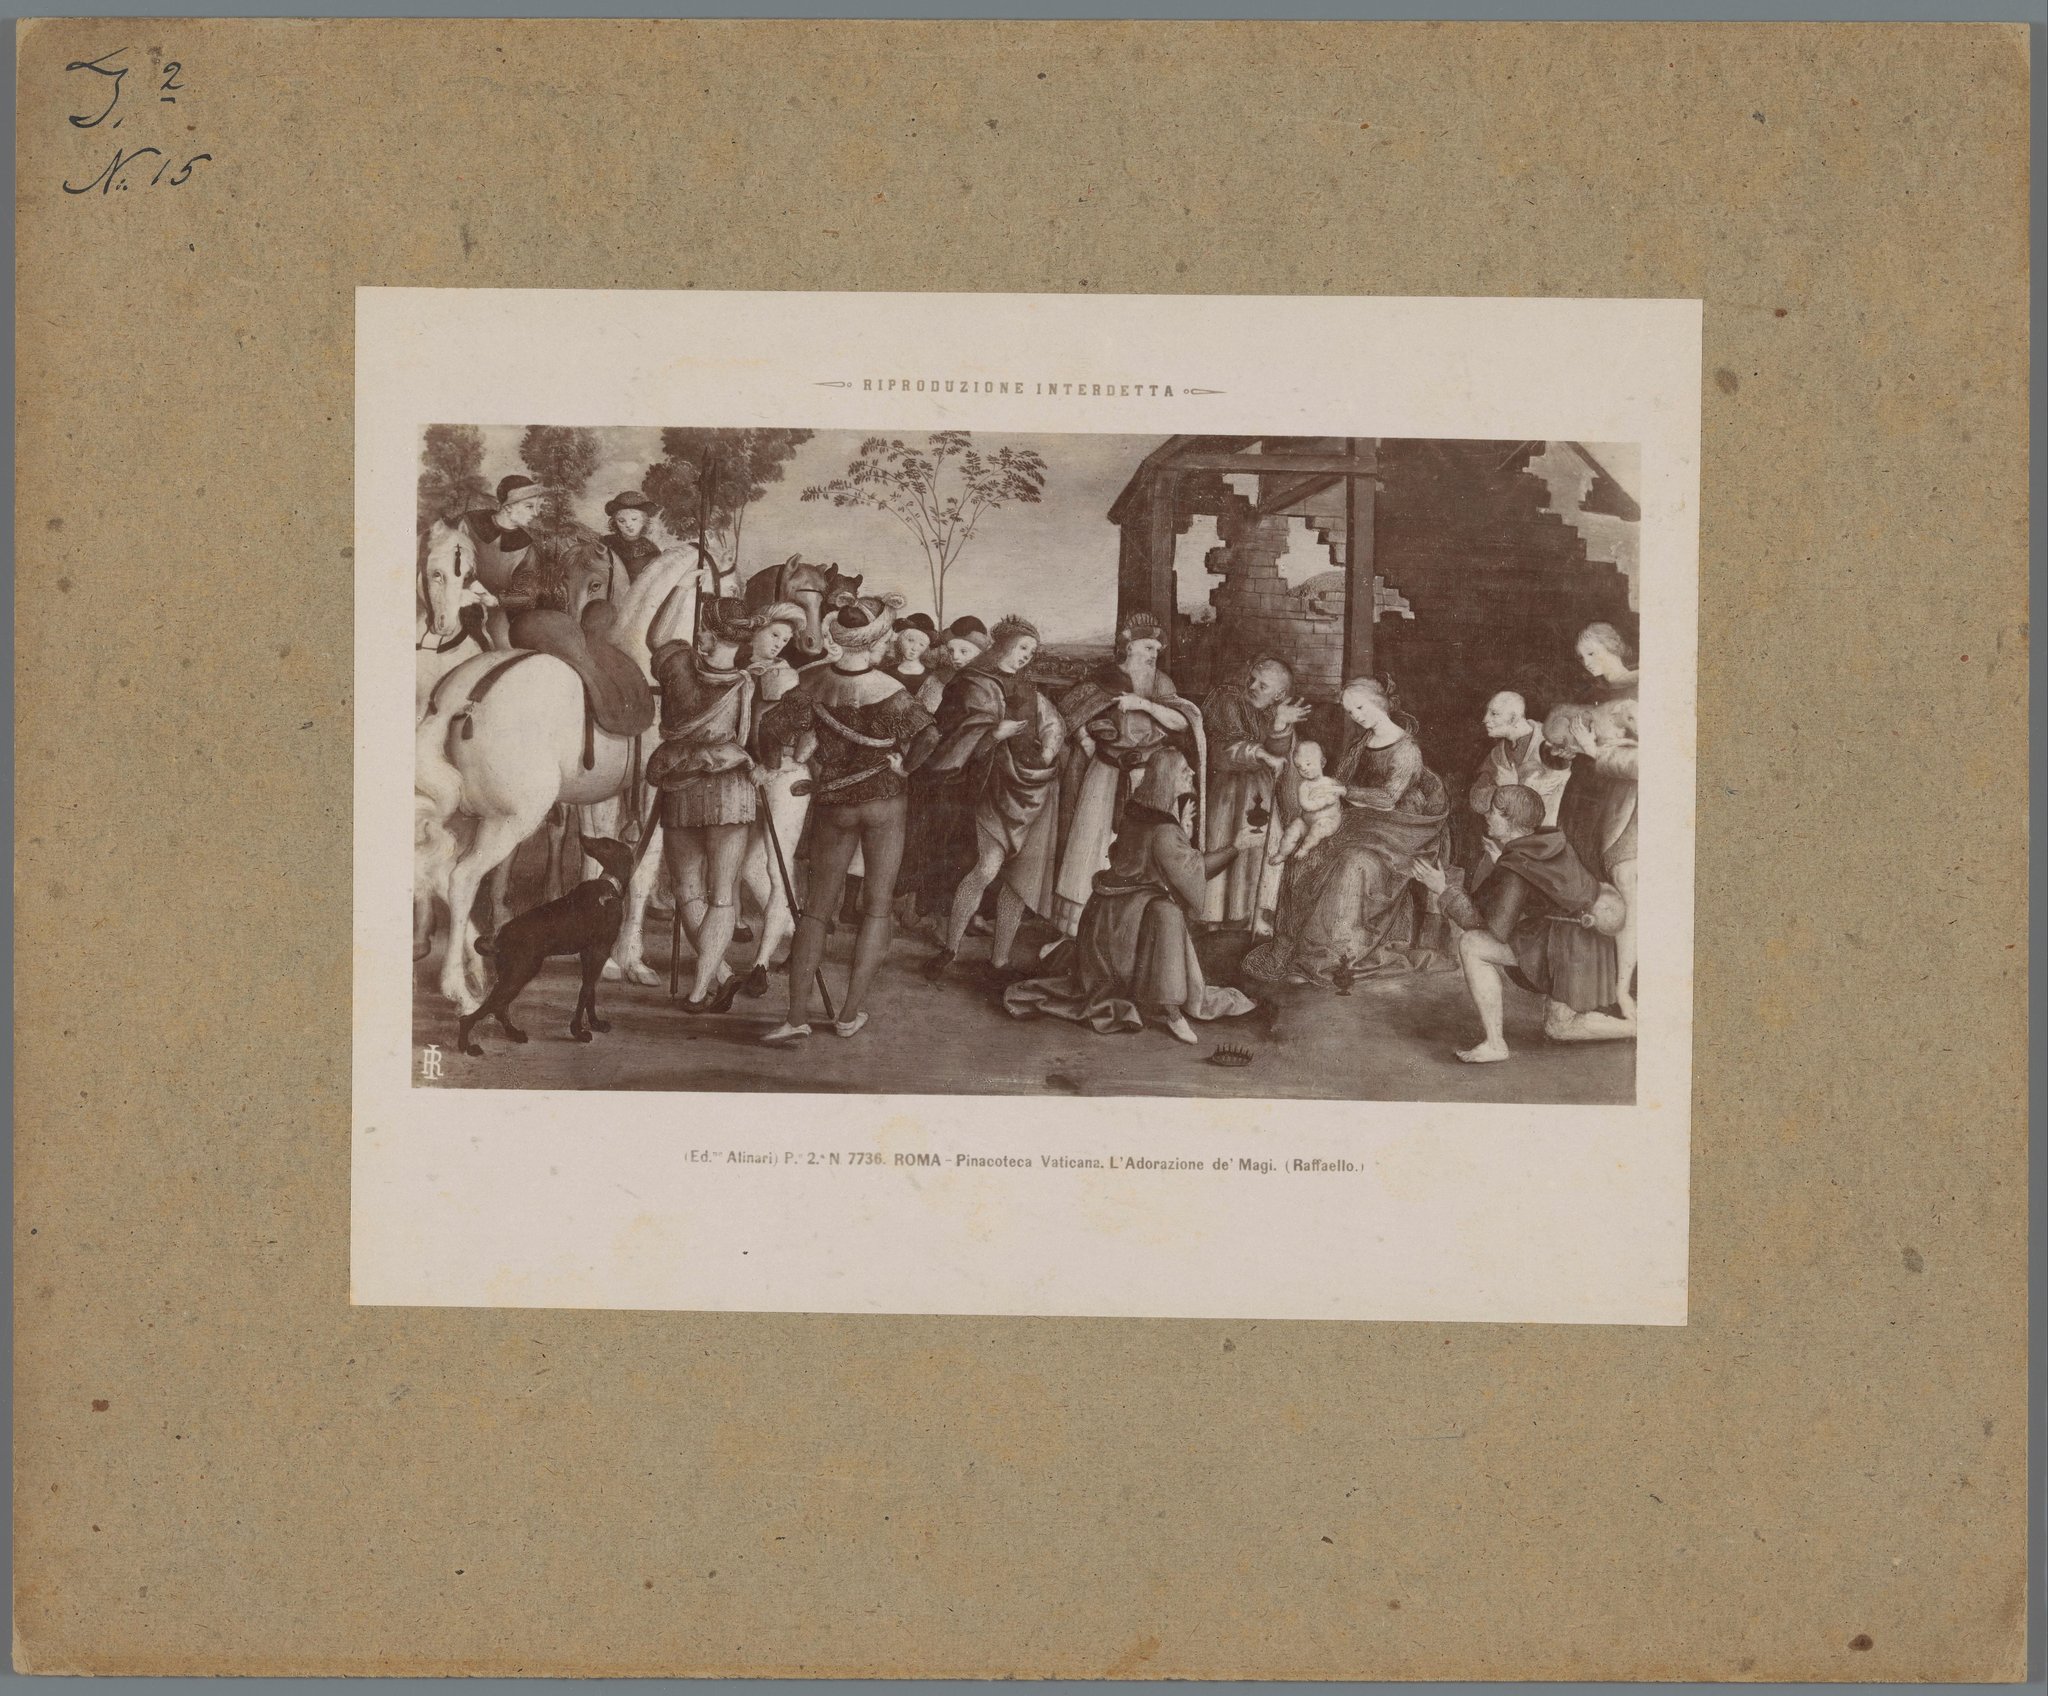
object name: reproduction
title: Fotoreproductie van een schilderij door Rafaël, voorstellende de aanbidding door de koningen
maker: rafaël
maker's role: painter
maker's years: 1483-1520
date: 1875-1900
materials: cardboard, photographic support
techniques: albumen print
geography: italy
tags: adoration of the kings: the wise men present their gifts to the christ-child (gold, frankincense and myrrh)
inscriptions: number: ‘P.e 2.a N.o 7736.’, inscription:, collector's mark: Lugt 3937